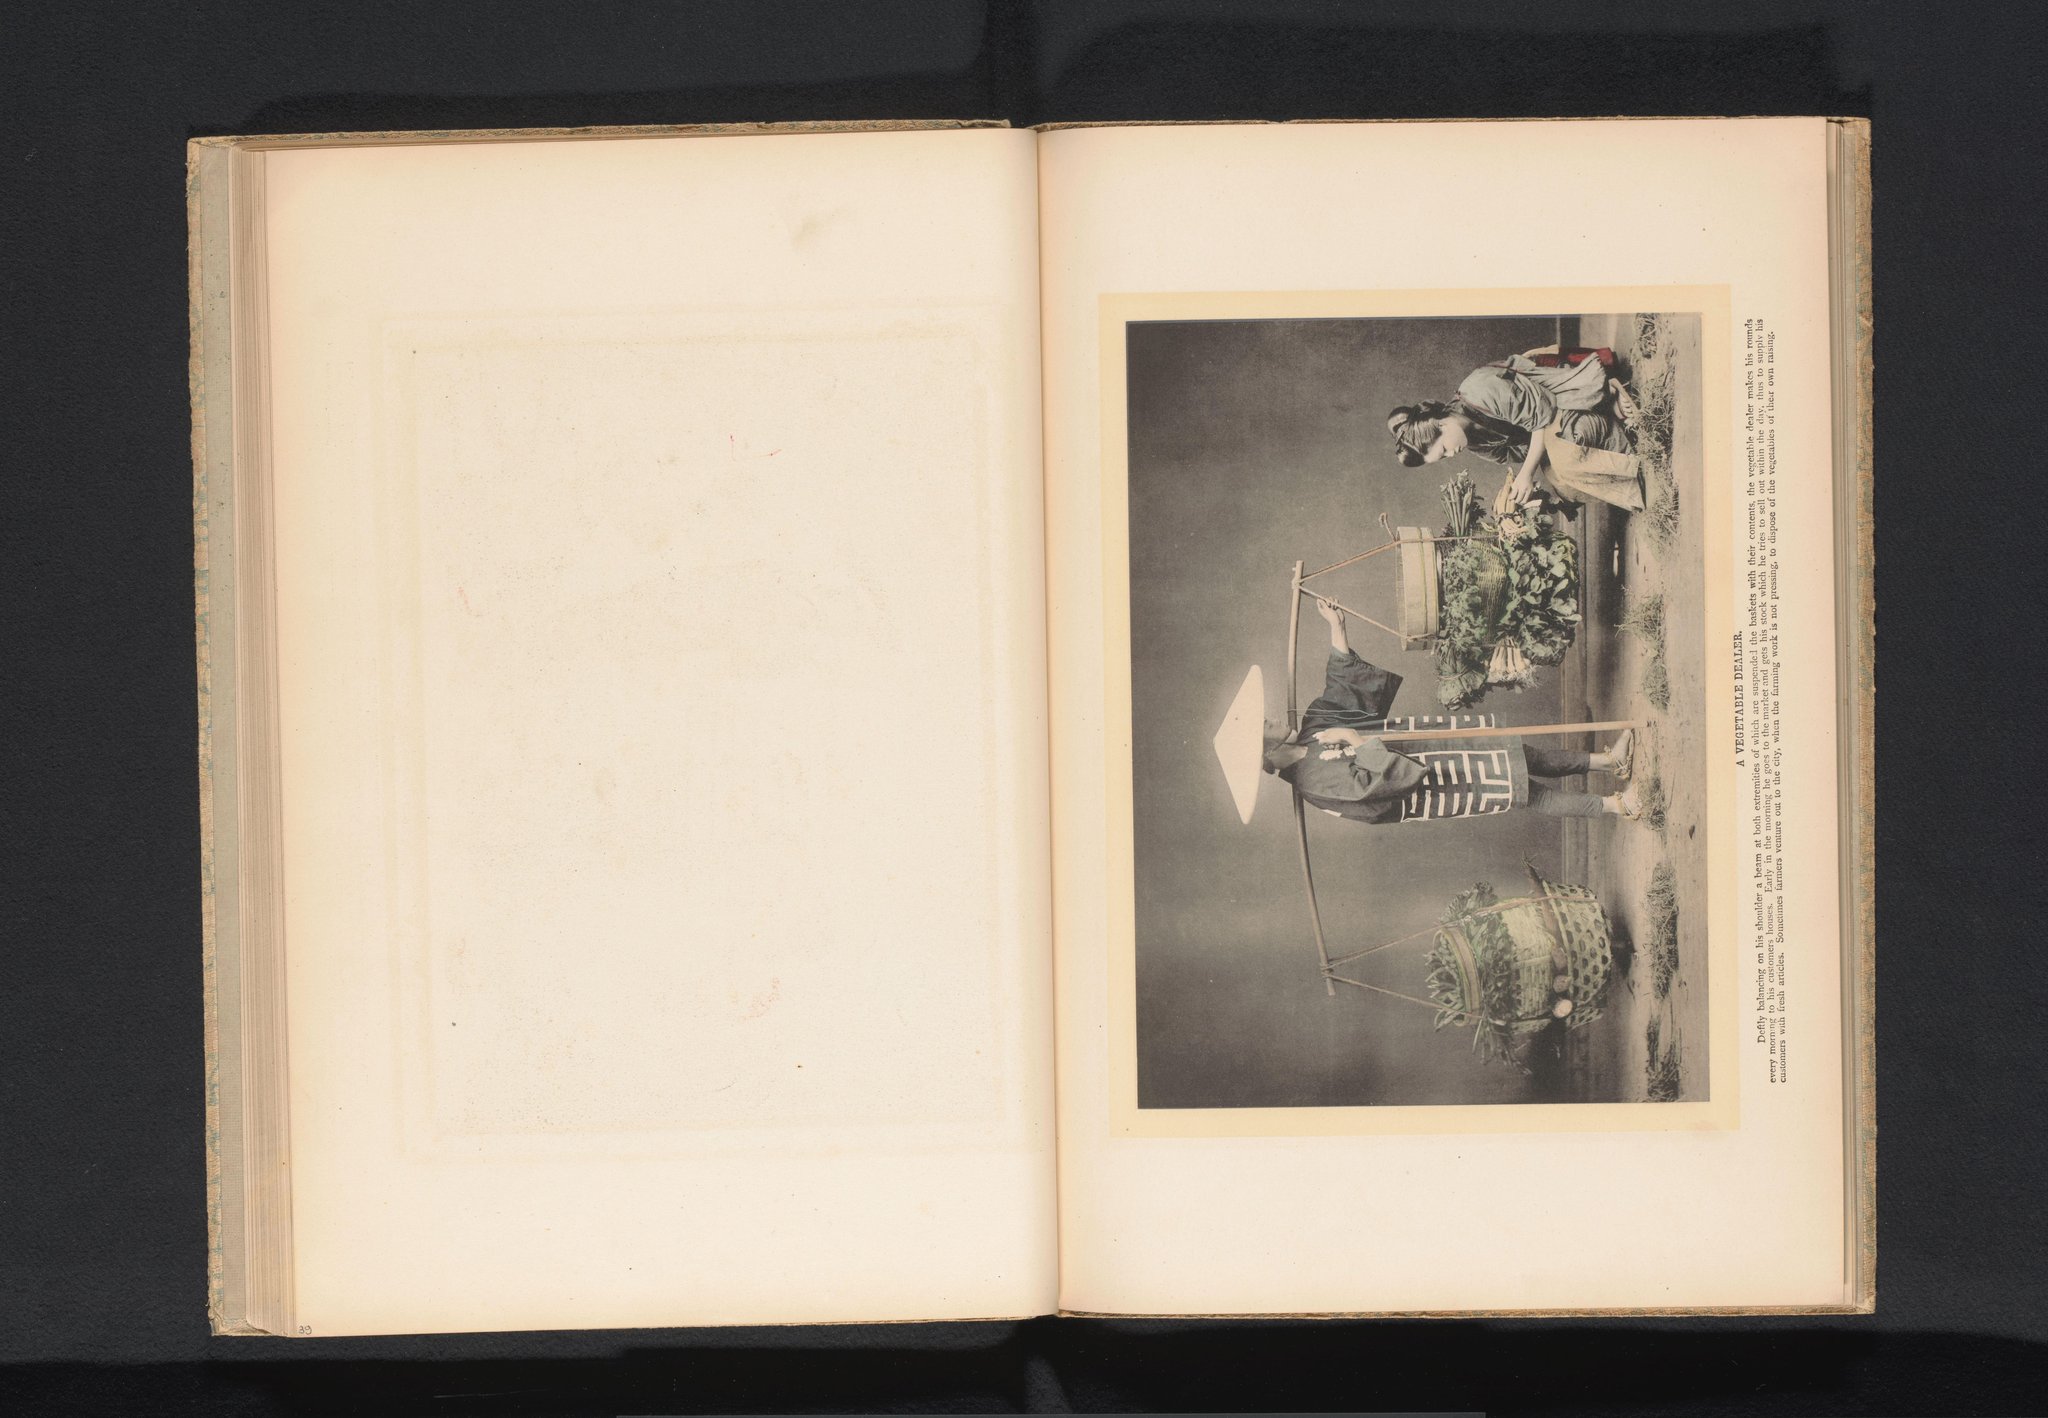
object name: photomechanical print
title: A Vegetable Dealer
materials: paper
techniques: photograph, lithograph, hand coloring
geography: tokyo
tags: merchant, salesman (with name of trade or profession), japan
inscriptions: inscription: ‘Deftly balancing (...) own raising.’